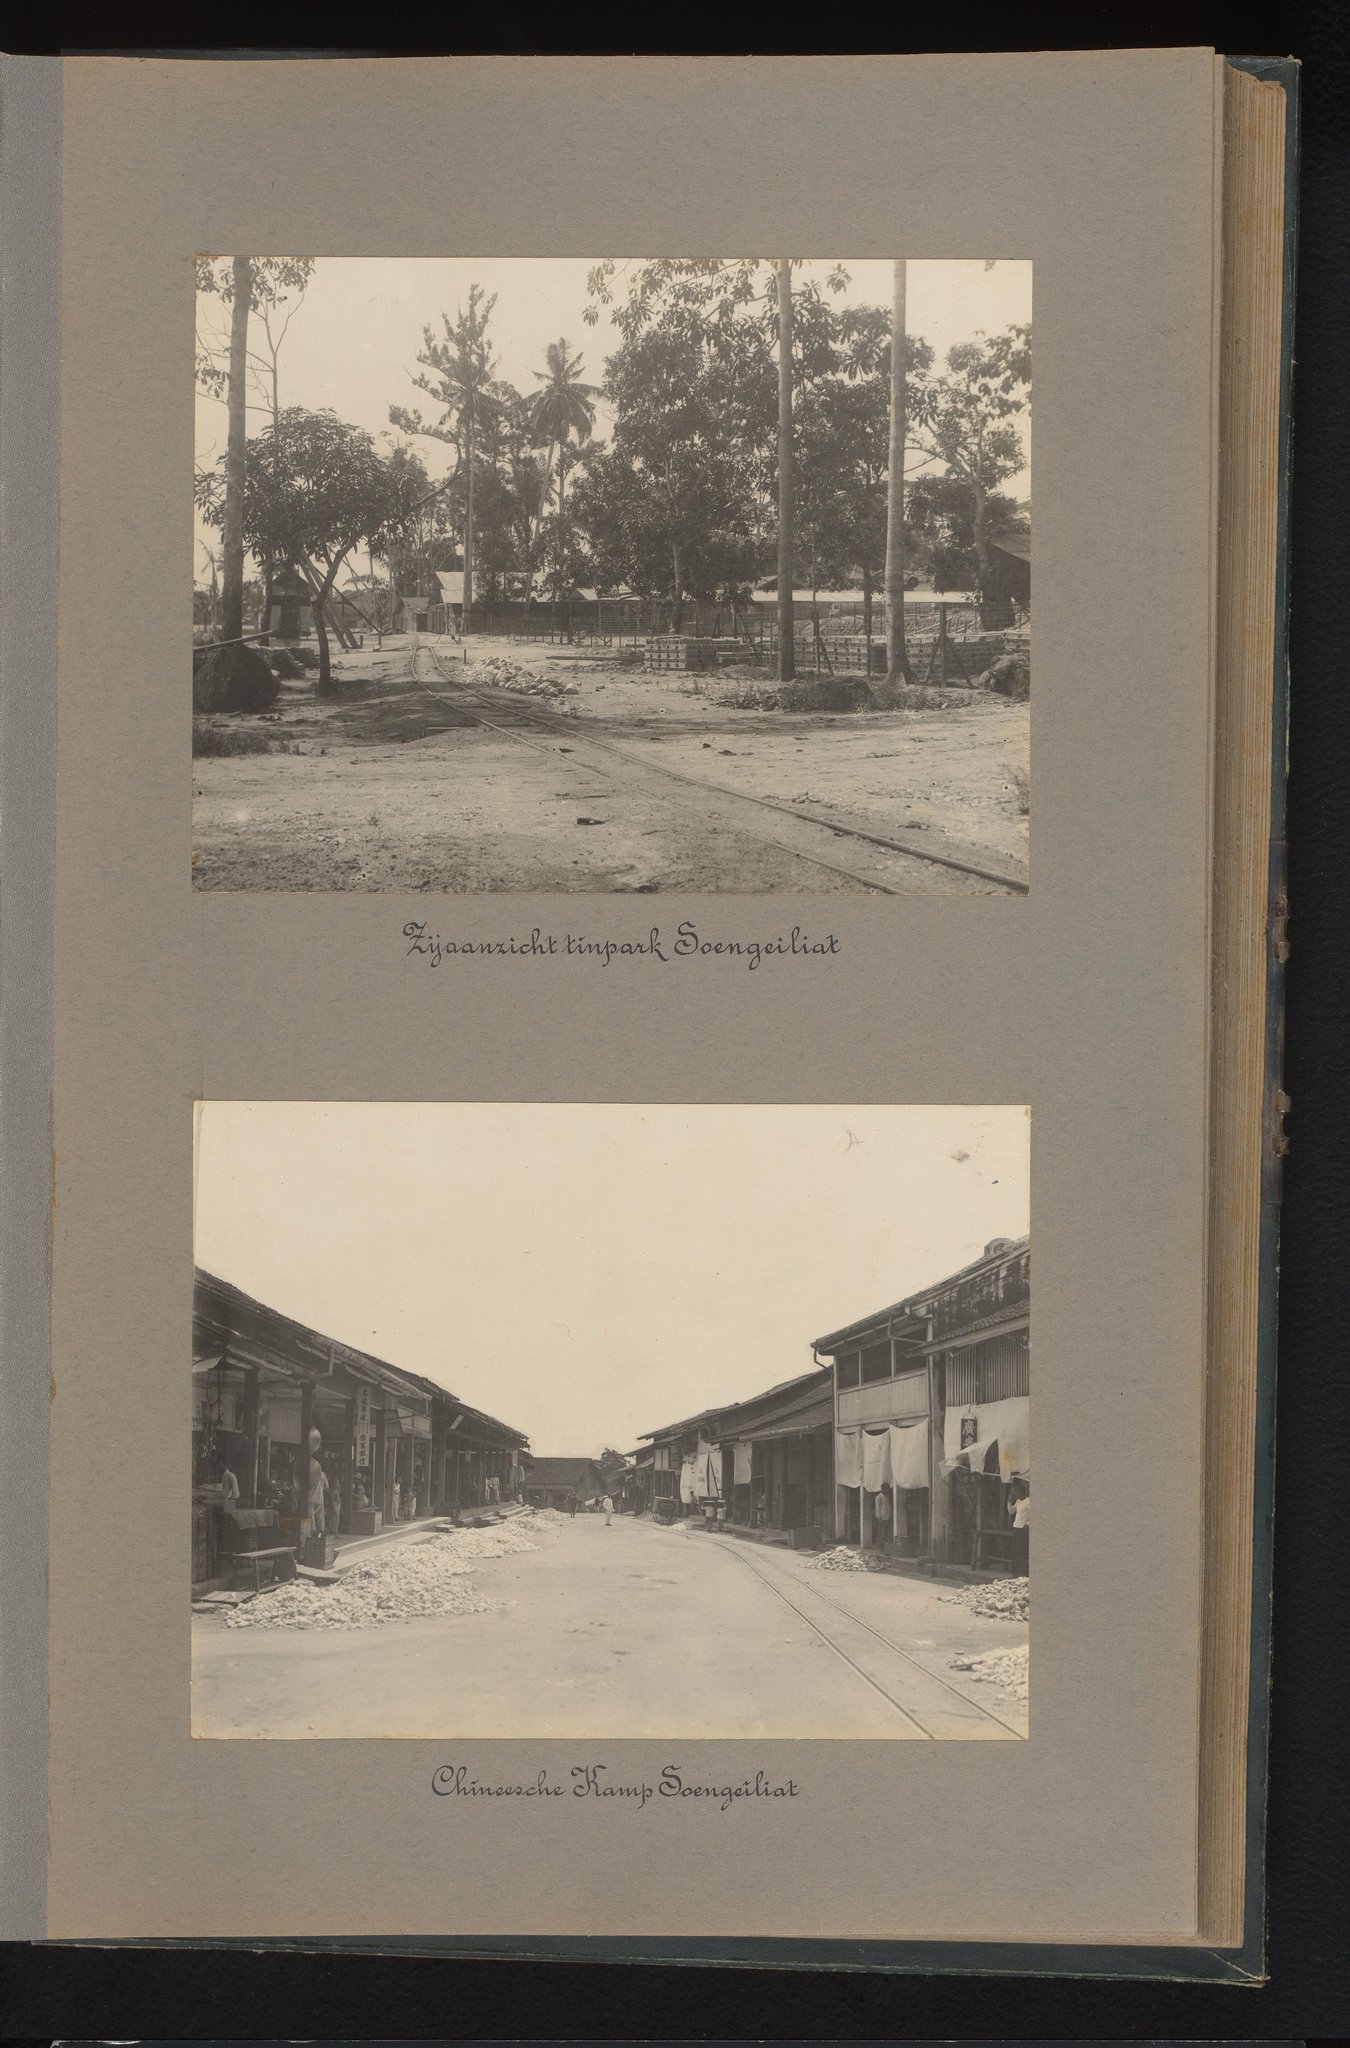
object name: album leaf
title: Tinpark en Chinese kamp van de Banka-tinwinning te Soengeiliat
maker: Anonymous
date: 1914-1919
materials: cardboard, photographic support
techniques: gelatin silver print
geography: bangka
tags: robert julius boers, colonial system, mining, the usual house or row of houses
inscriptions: inscription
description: Albumblad met 2 foto's van het tinpark en de Chinese kamp van de Banka-tinwinning te Soengeiliat. Onderdeel van het fotoalbum aangeboden aan Robert Julius Boers bij zijn vertrek naar Nederland in 1919 door het personeel van de Banka-tinwinning.